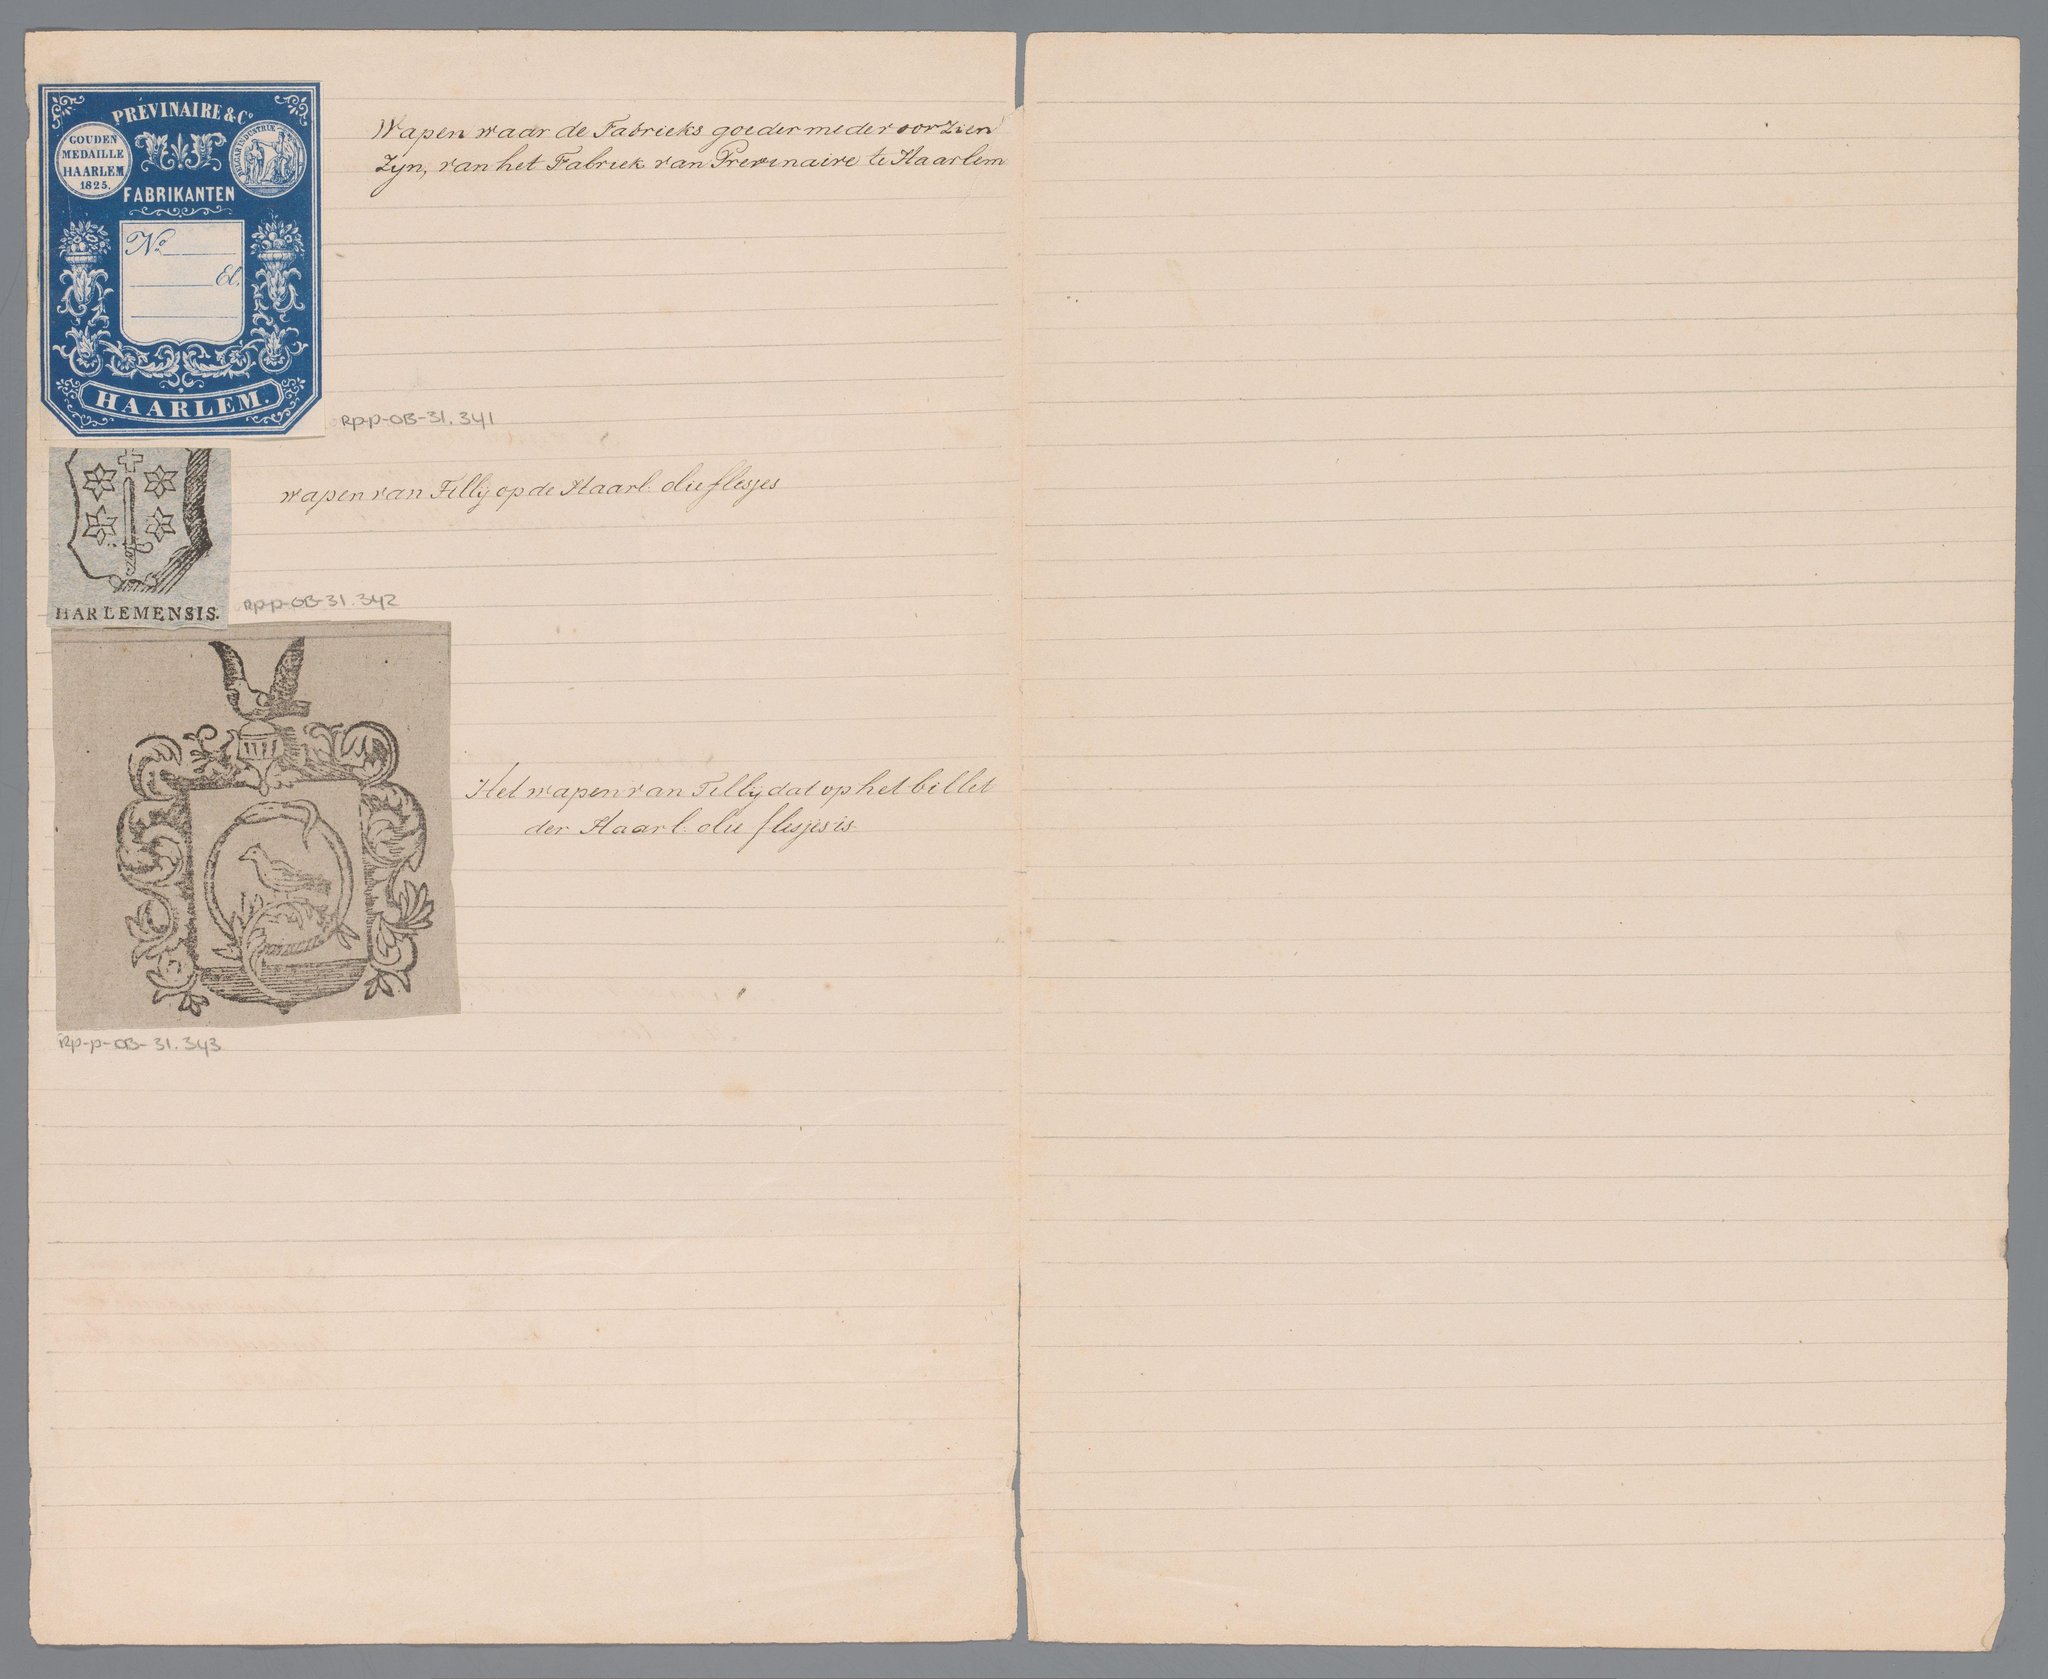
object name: print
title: Vignet met het wapen van de stad Haarlem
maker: Anonymous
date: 1600-1699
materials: paper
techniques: woodcut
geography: netherlands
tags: coat of arms (as symbol of the state, etc.) (+ city; municipal), vignette, haarlem